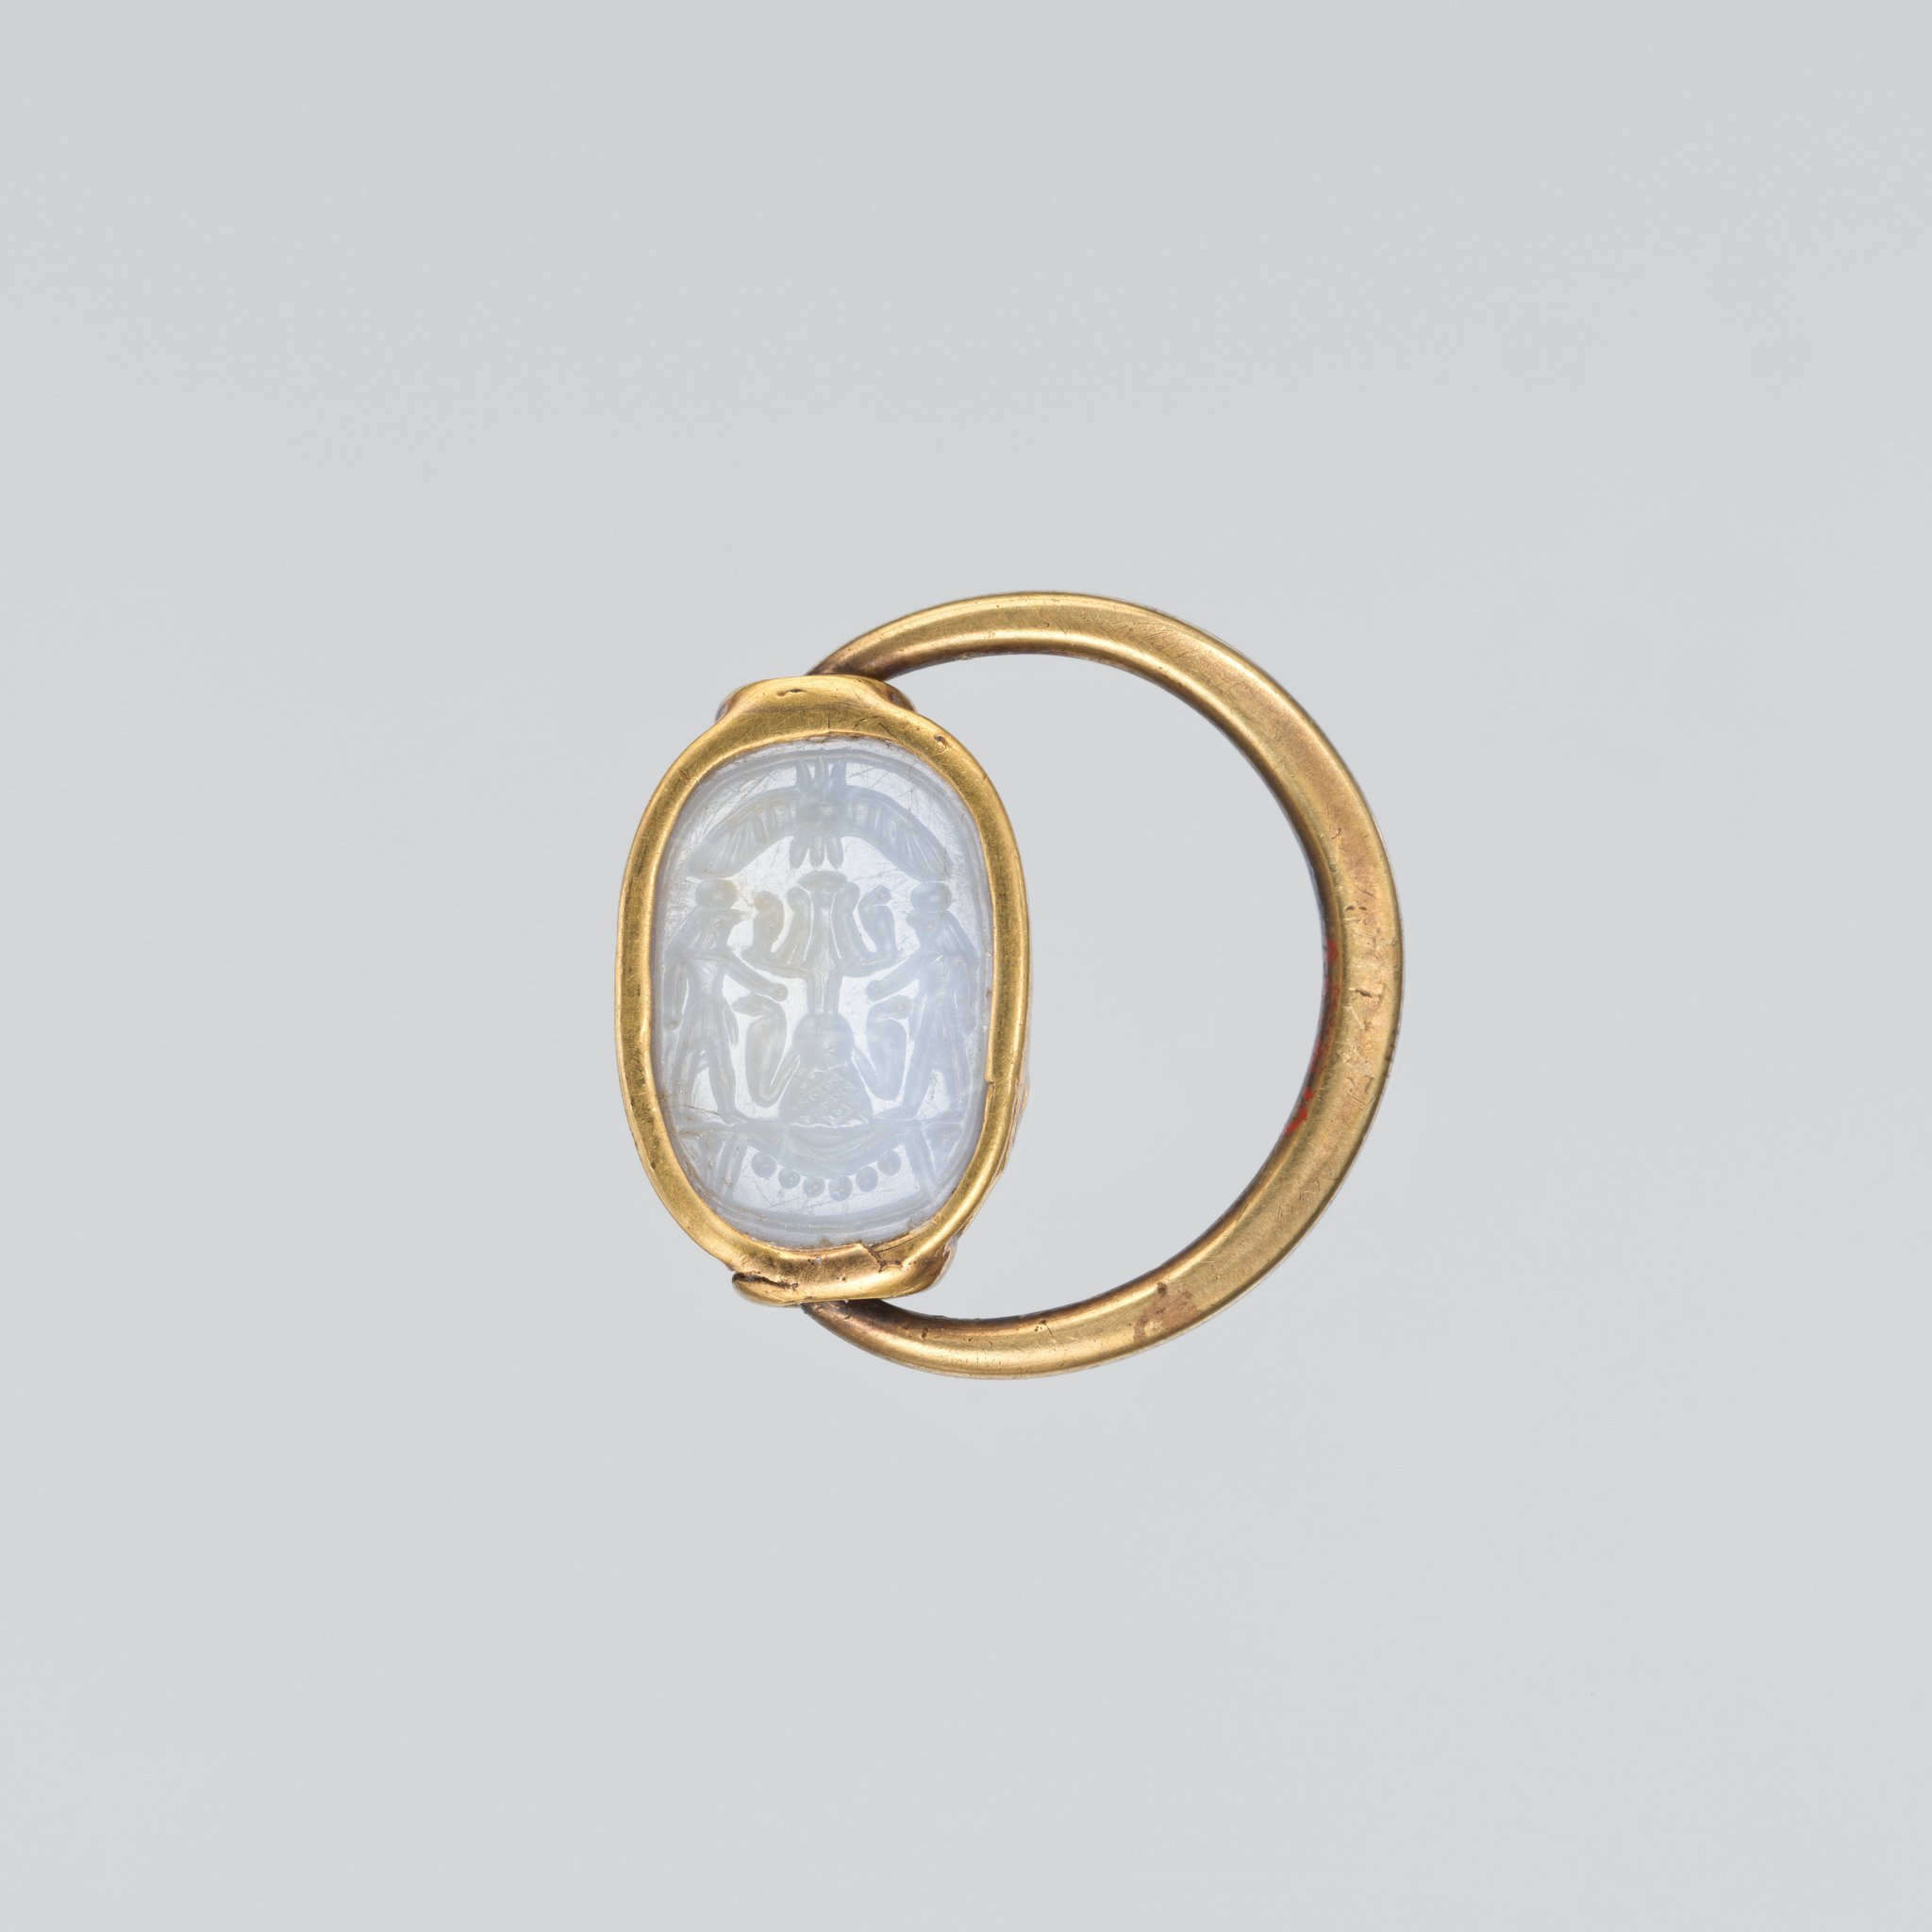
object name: ring with scaraboid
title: Gold ring with chalcedony scaraboid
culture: cypriot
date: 600-501 BCE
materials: stone, gold